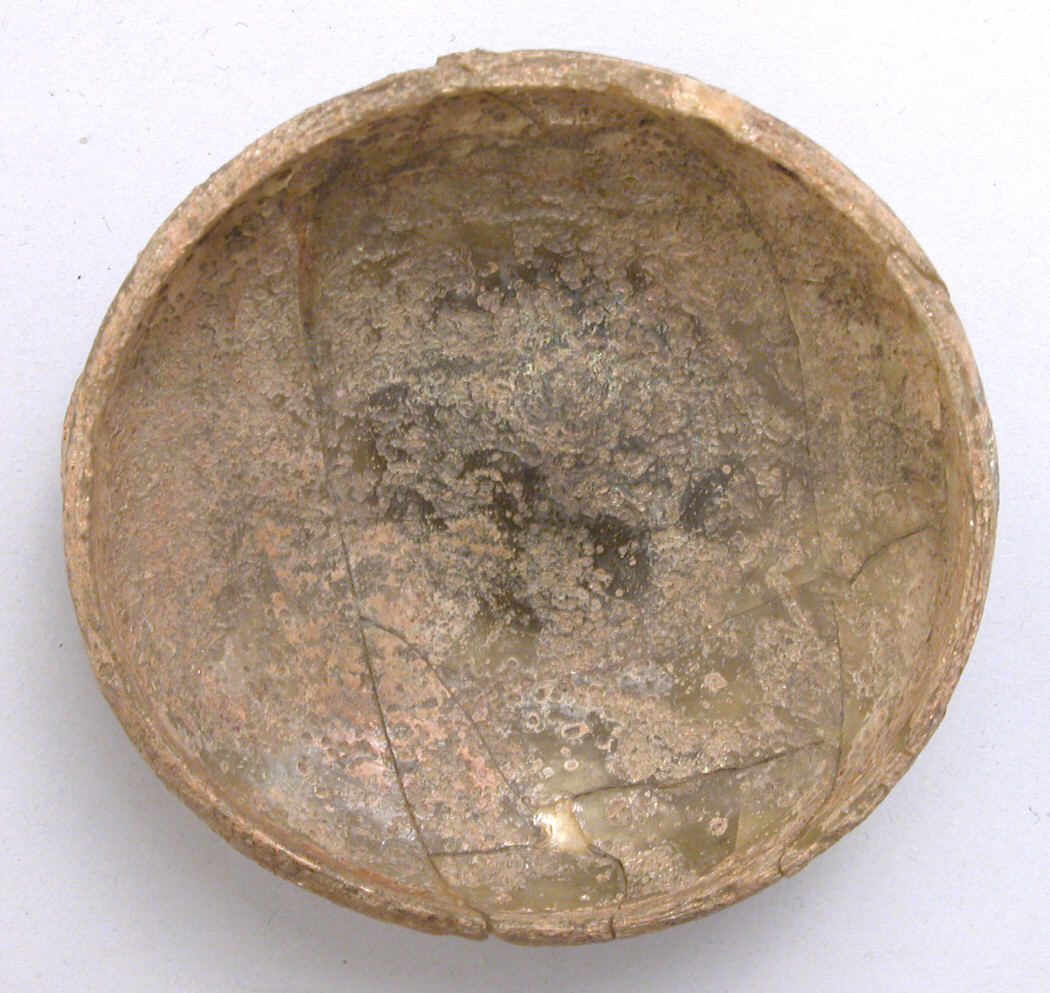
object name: bowl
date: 701-900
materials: glass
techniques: glassblowing, tooling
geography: iraq